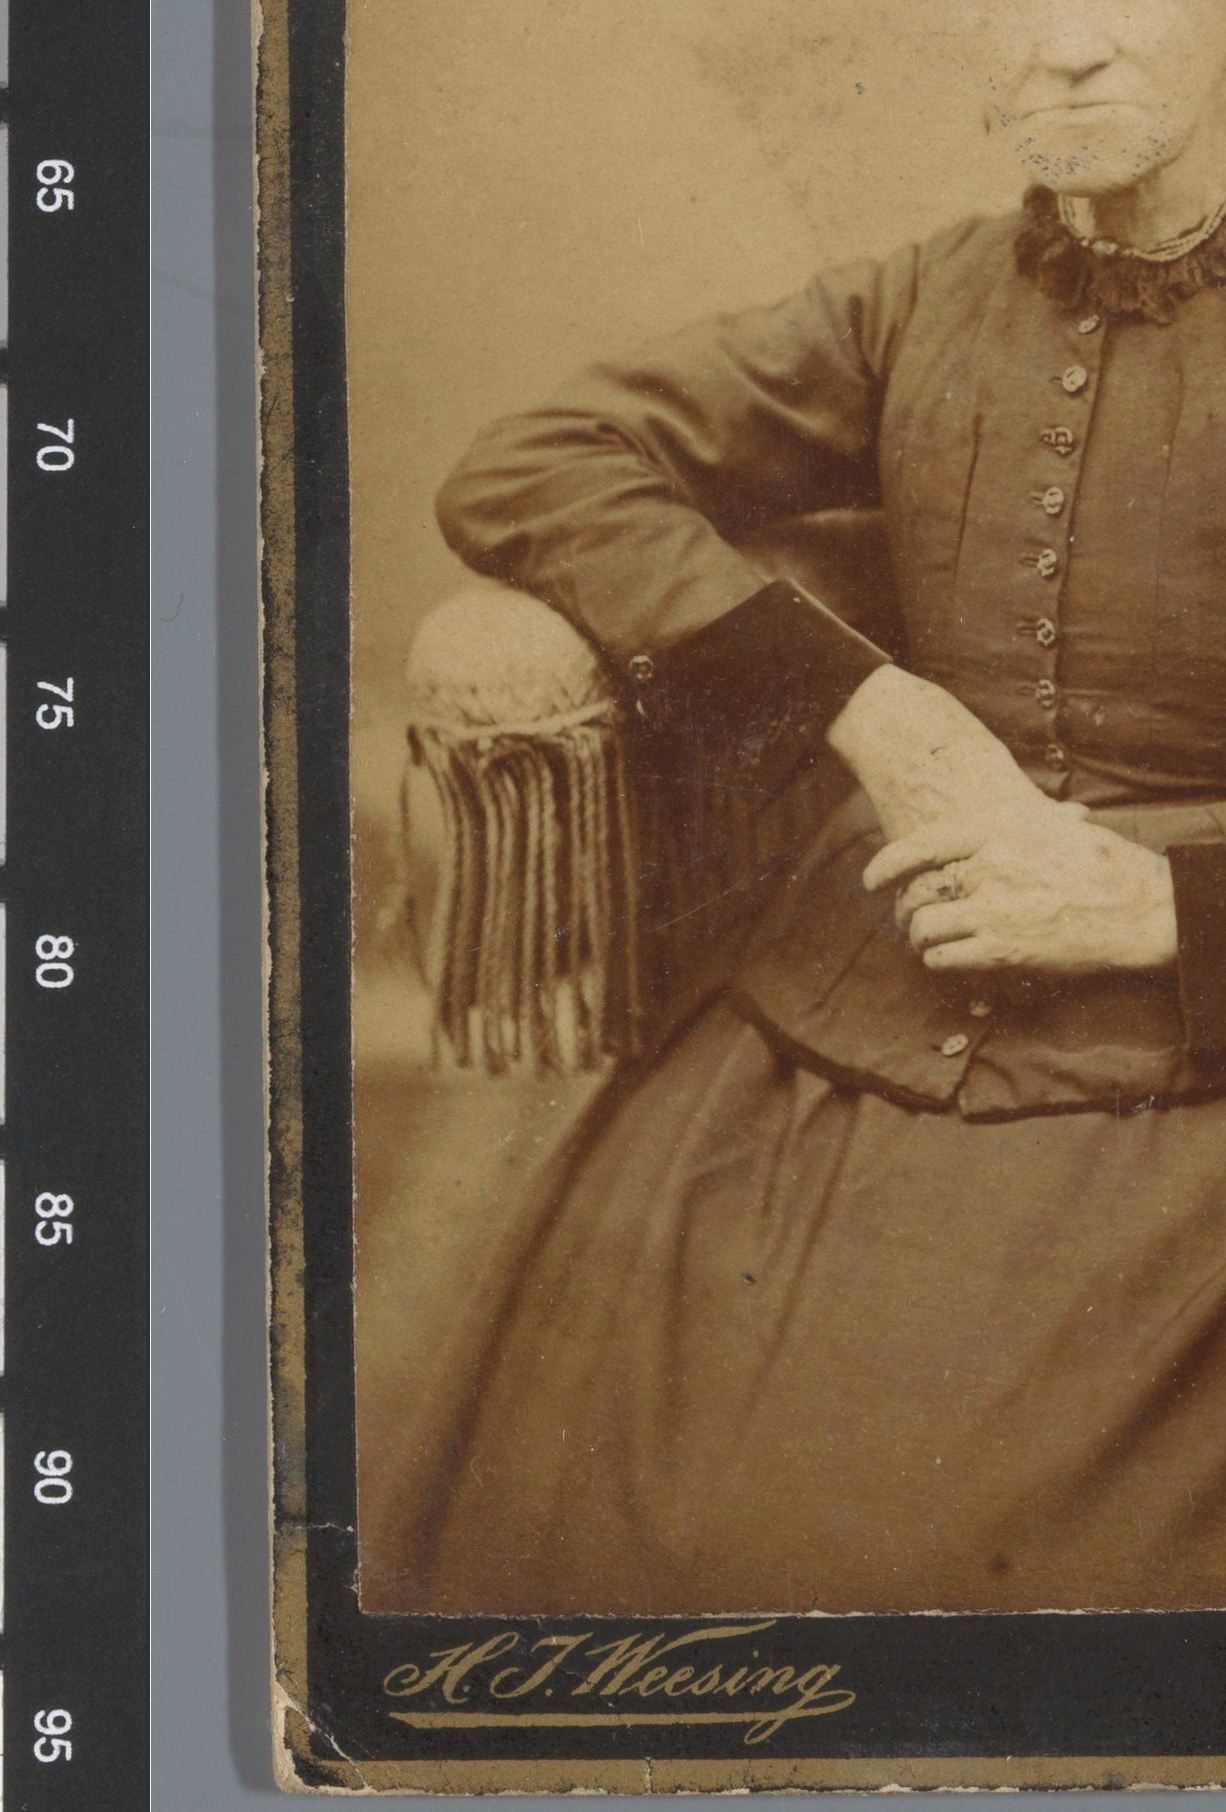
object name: photograph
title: Portret van een onbekende zittende vrouw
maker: hermanus jodocus weesing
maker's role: fotograaf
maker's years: 1844-1910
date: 1868-1900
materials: cardboard, paper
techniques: albumen print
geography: amsterdam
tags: sitting figure, historical persons - bb - woman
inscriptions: inscription: ‘H. J. Weesing/ PHOTOGRAPHE/ AMSTERDAM. Binnen Brouwerstraat 5.’